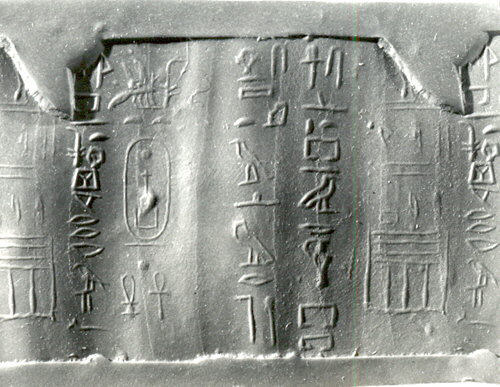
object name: cylinder seal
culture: egyptian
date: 2289-2255 BCE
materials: quartz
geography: egypt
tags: hieroglyphs